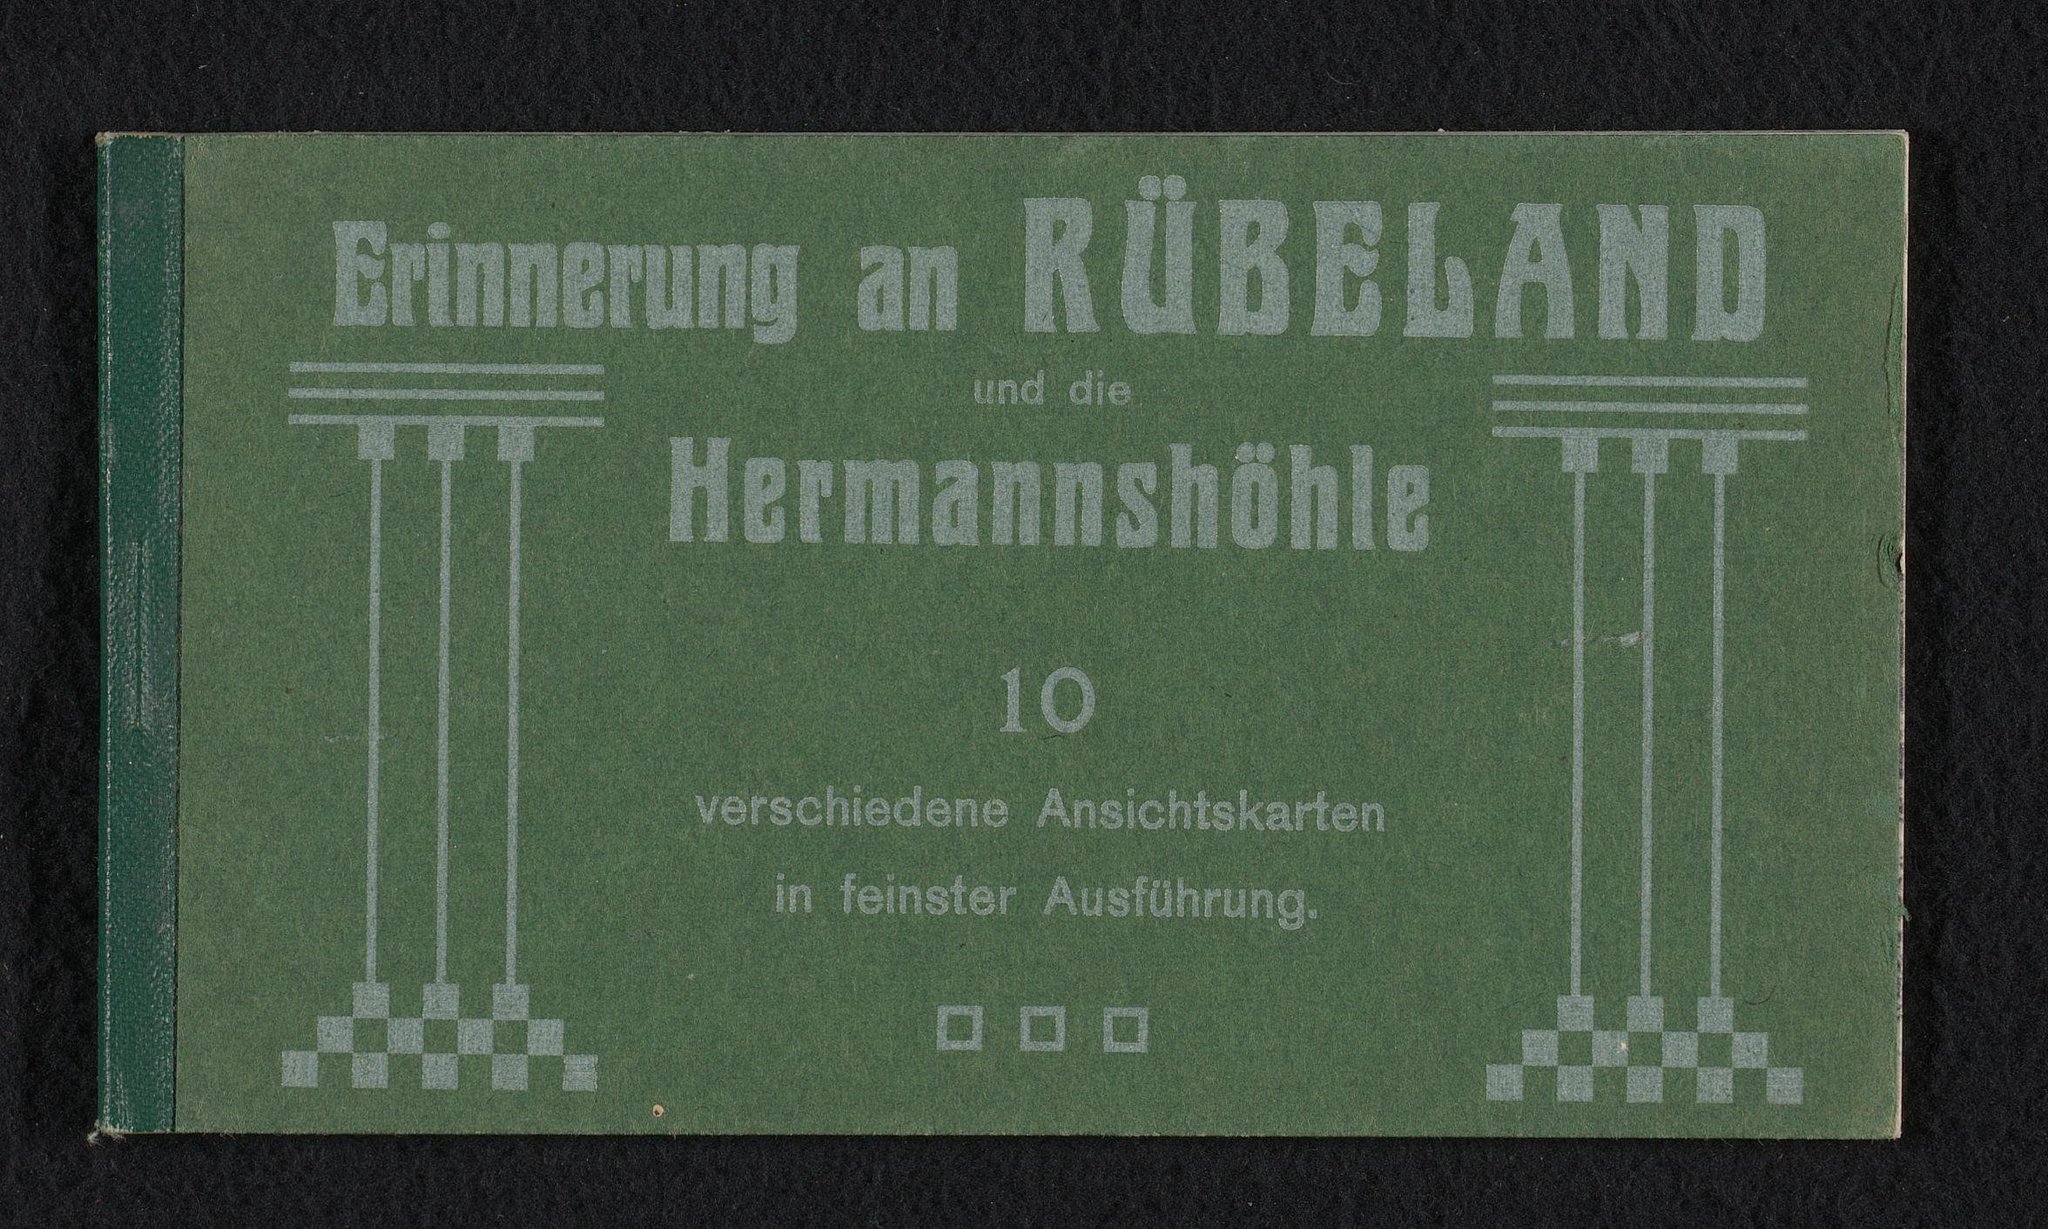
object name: album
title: Erinnerung an Rübeland und die Hermannshöhle. 10 verschiedene Ansichtskarten in feinster Ausführung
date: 1907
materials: cardboard, paper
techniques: photograph, printing block, stapling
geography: halberstadt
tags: stalactitic cave, city-view, and landscape with man-made constructions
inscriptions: date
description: Album met tien prentbriefkaarten met voorstellingen van Rübeland en de Hermannshöhle. De prentbriefkaarten kunnen eruit gescheurd worden.